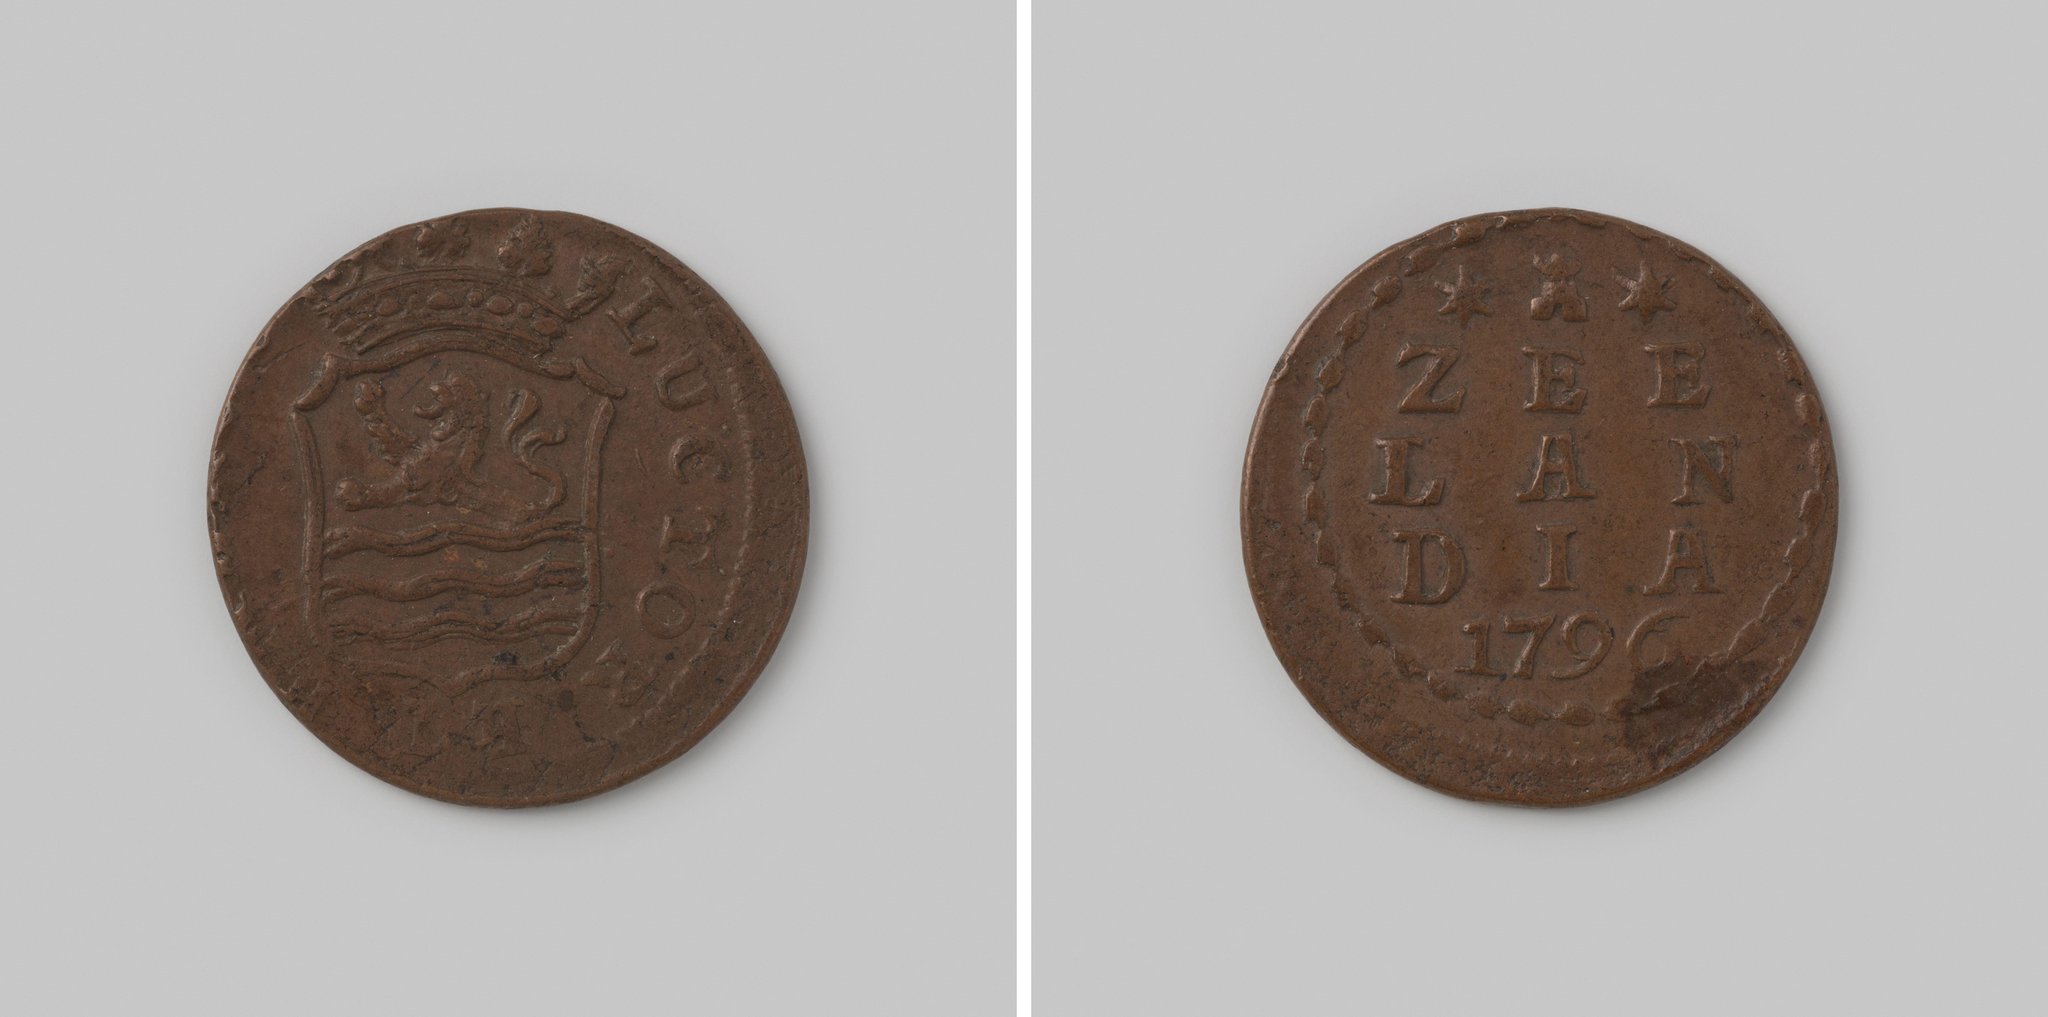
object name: coin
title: Bataafse Republiek, duit op naam van Zeeland, 1796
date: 1796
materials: copper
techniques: striking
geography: middelburg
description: Koperen munt. Voorzijde: gekroond, zijdelings ingedeukt wapenschild van Zeeland. Keerzijde: in een krans opschrift in drie regels, waarboven muntteken burcht tussen twee sterren en waaronder jaartal.